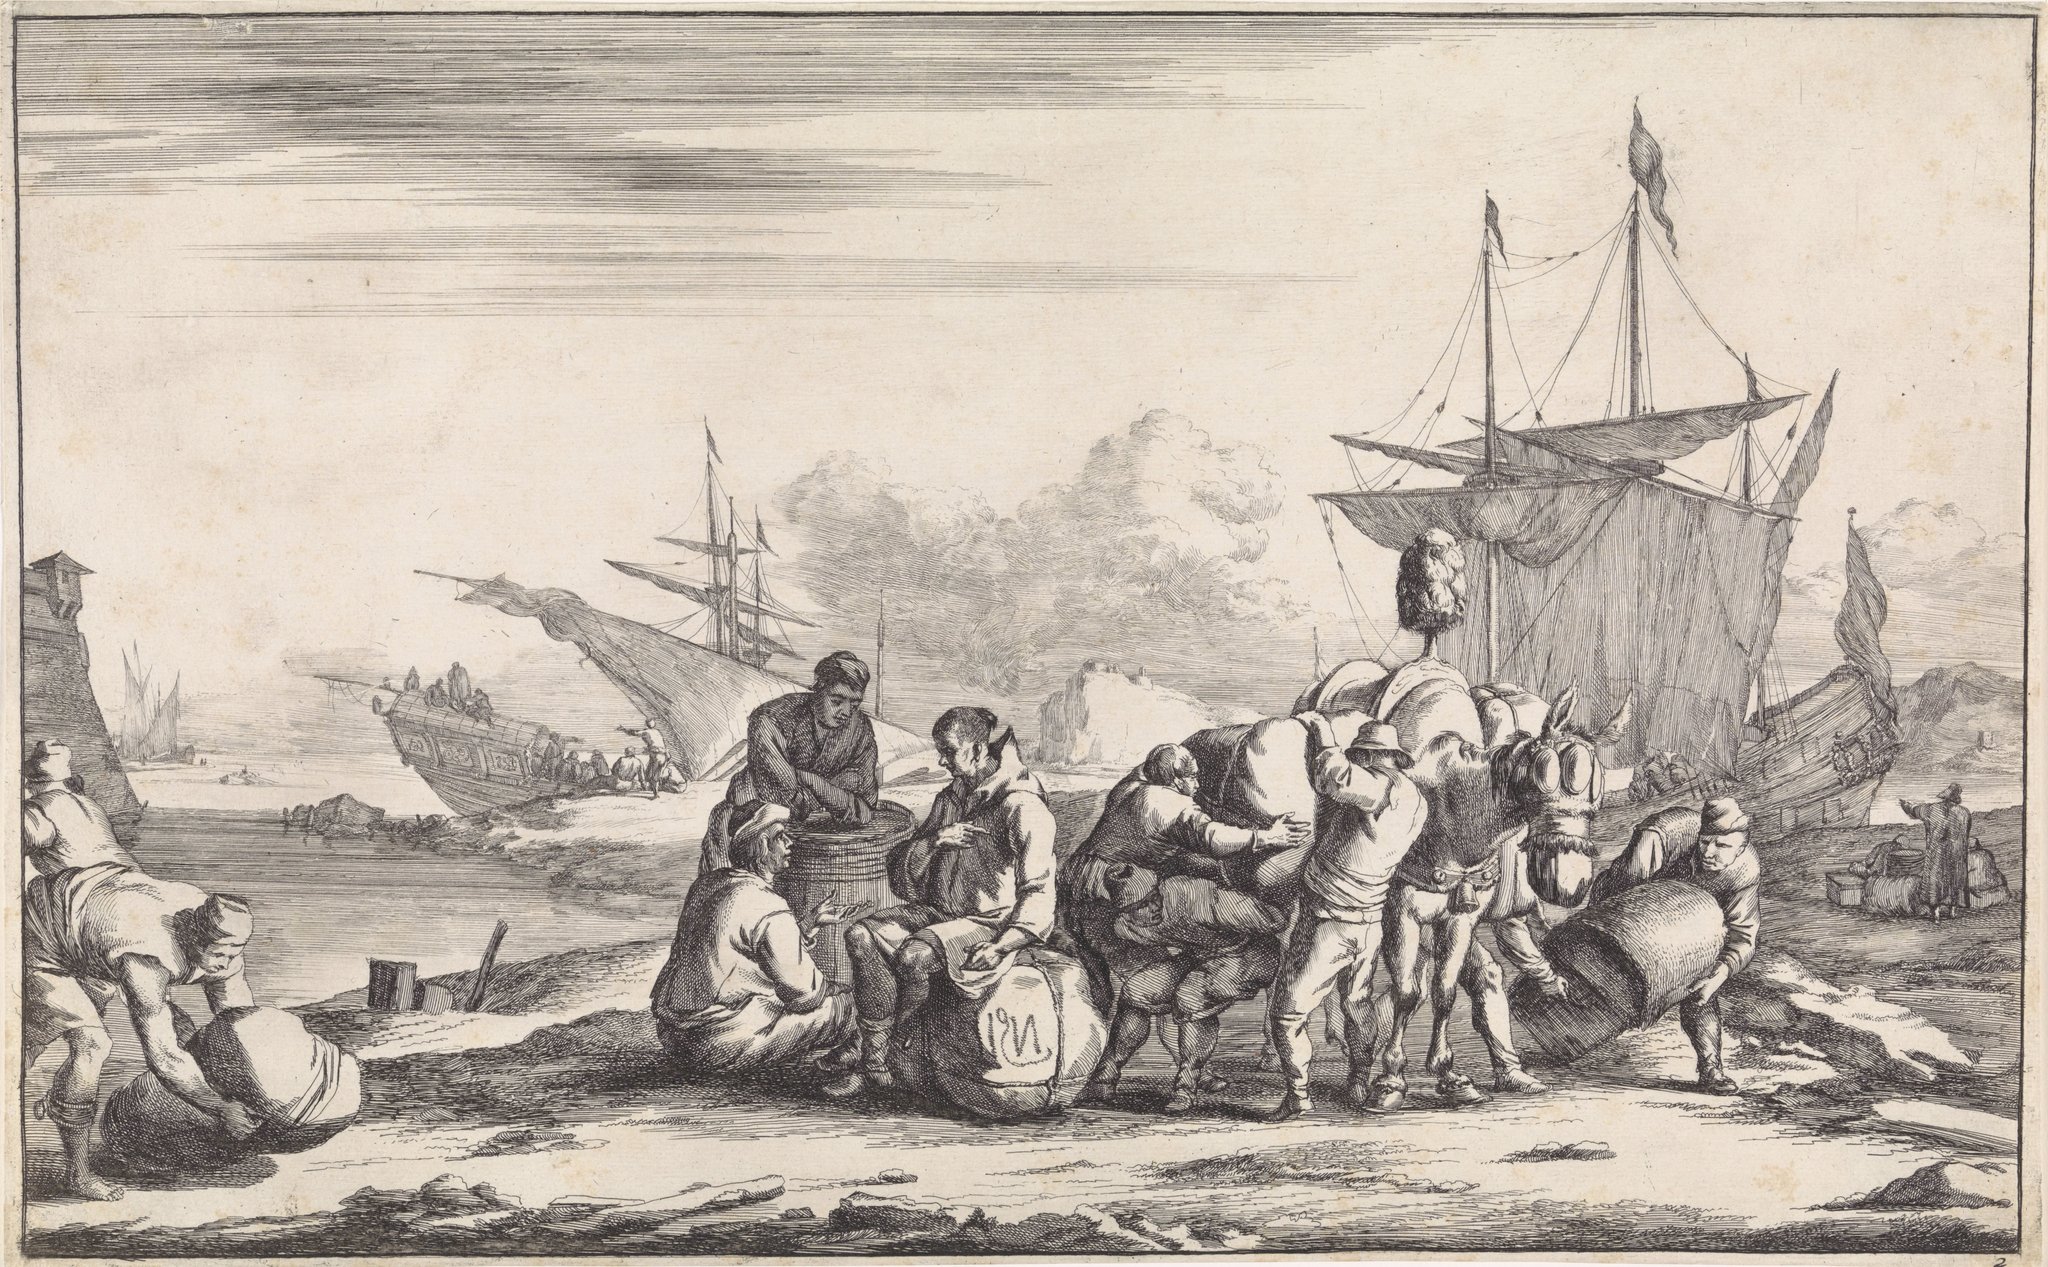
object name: print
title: Havens van Genua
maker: anthony van zijlvelt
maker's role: print maker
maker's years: 1637-1715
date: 1650-1695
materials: paper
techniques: etching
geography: amsterdam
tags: harbour, sailing-ship, sailing-boat, ass, donkey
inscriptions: collector's mark: Lugt 11, collector's mark: Lugt 10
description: In de haven van Genua spreken drie mensen met elkaar bij een ton. Een aantal mannen beladen een pakezel. Op de achtergrond schepen.